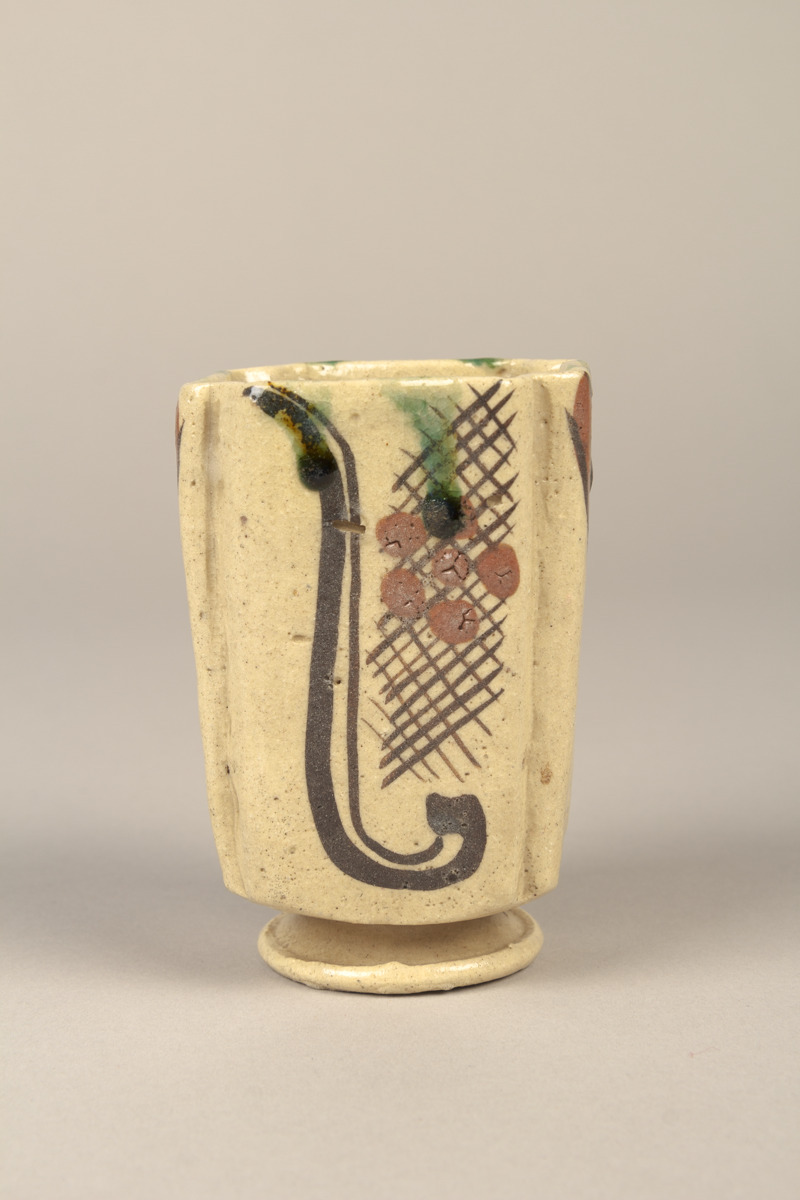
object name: food vessel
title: One from set of five squared food vessels (mukōzuke) for tea-gathering meal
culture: japanese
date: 1601-1633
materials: copper, iron, stoneware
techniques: overglaze